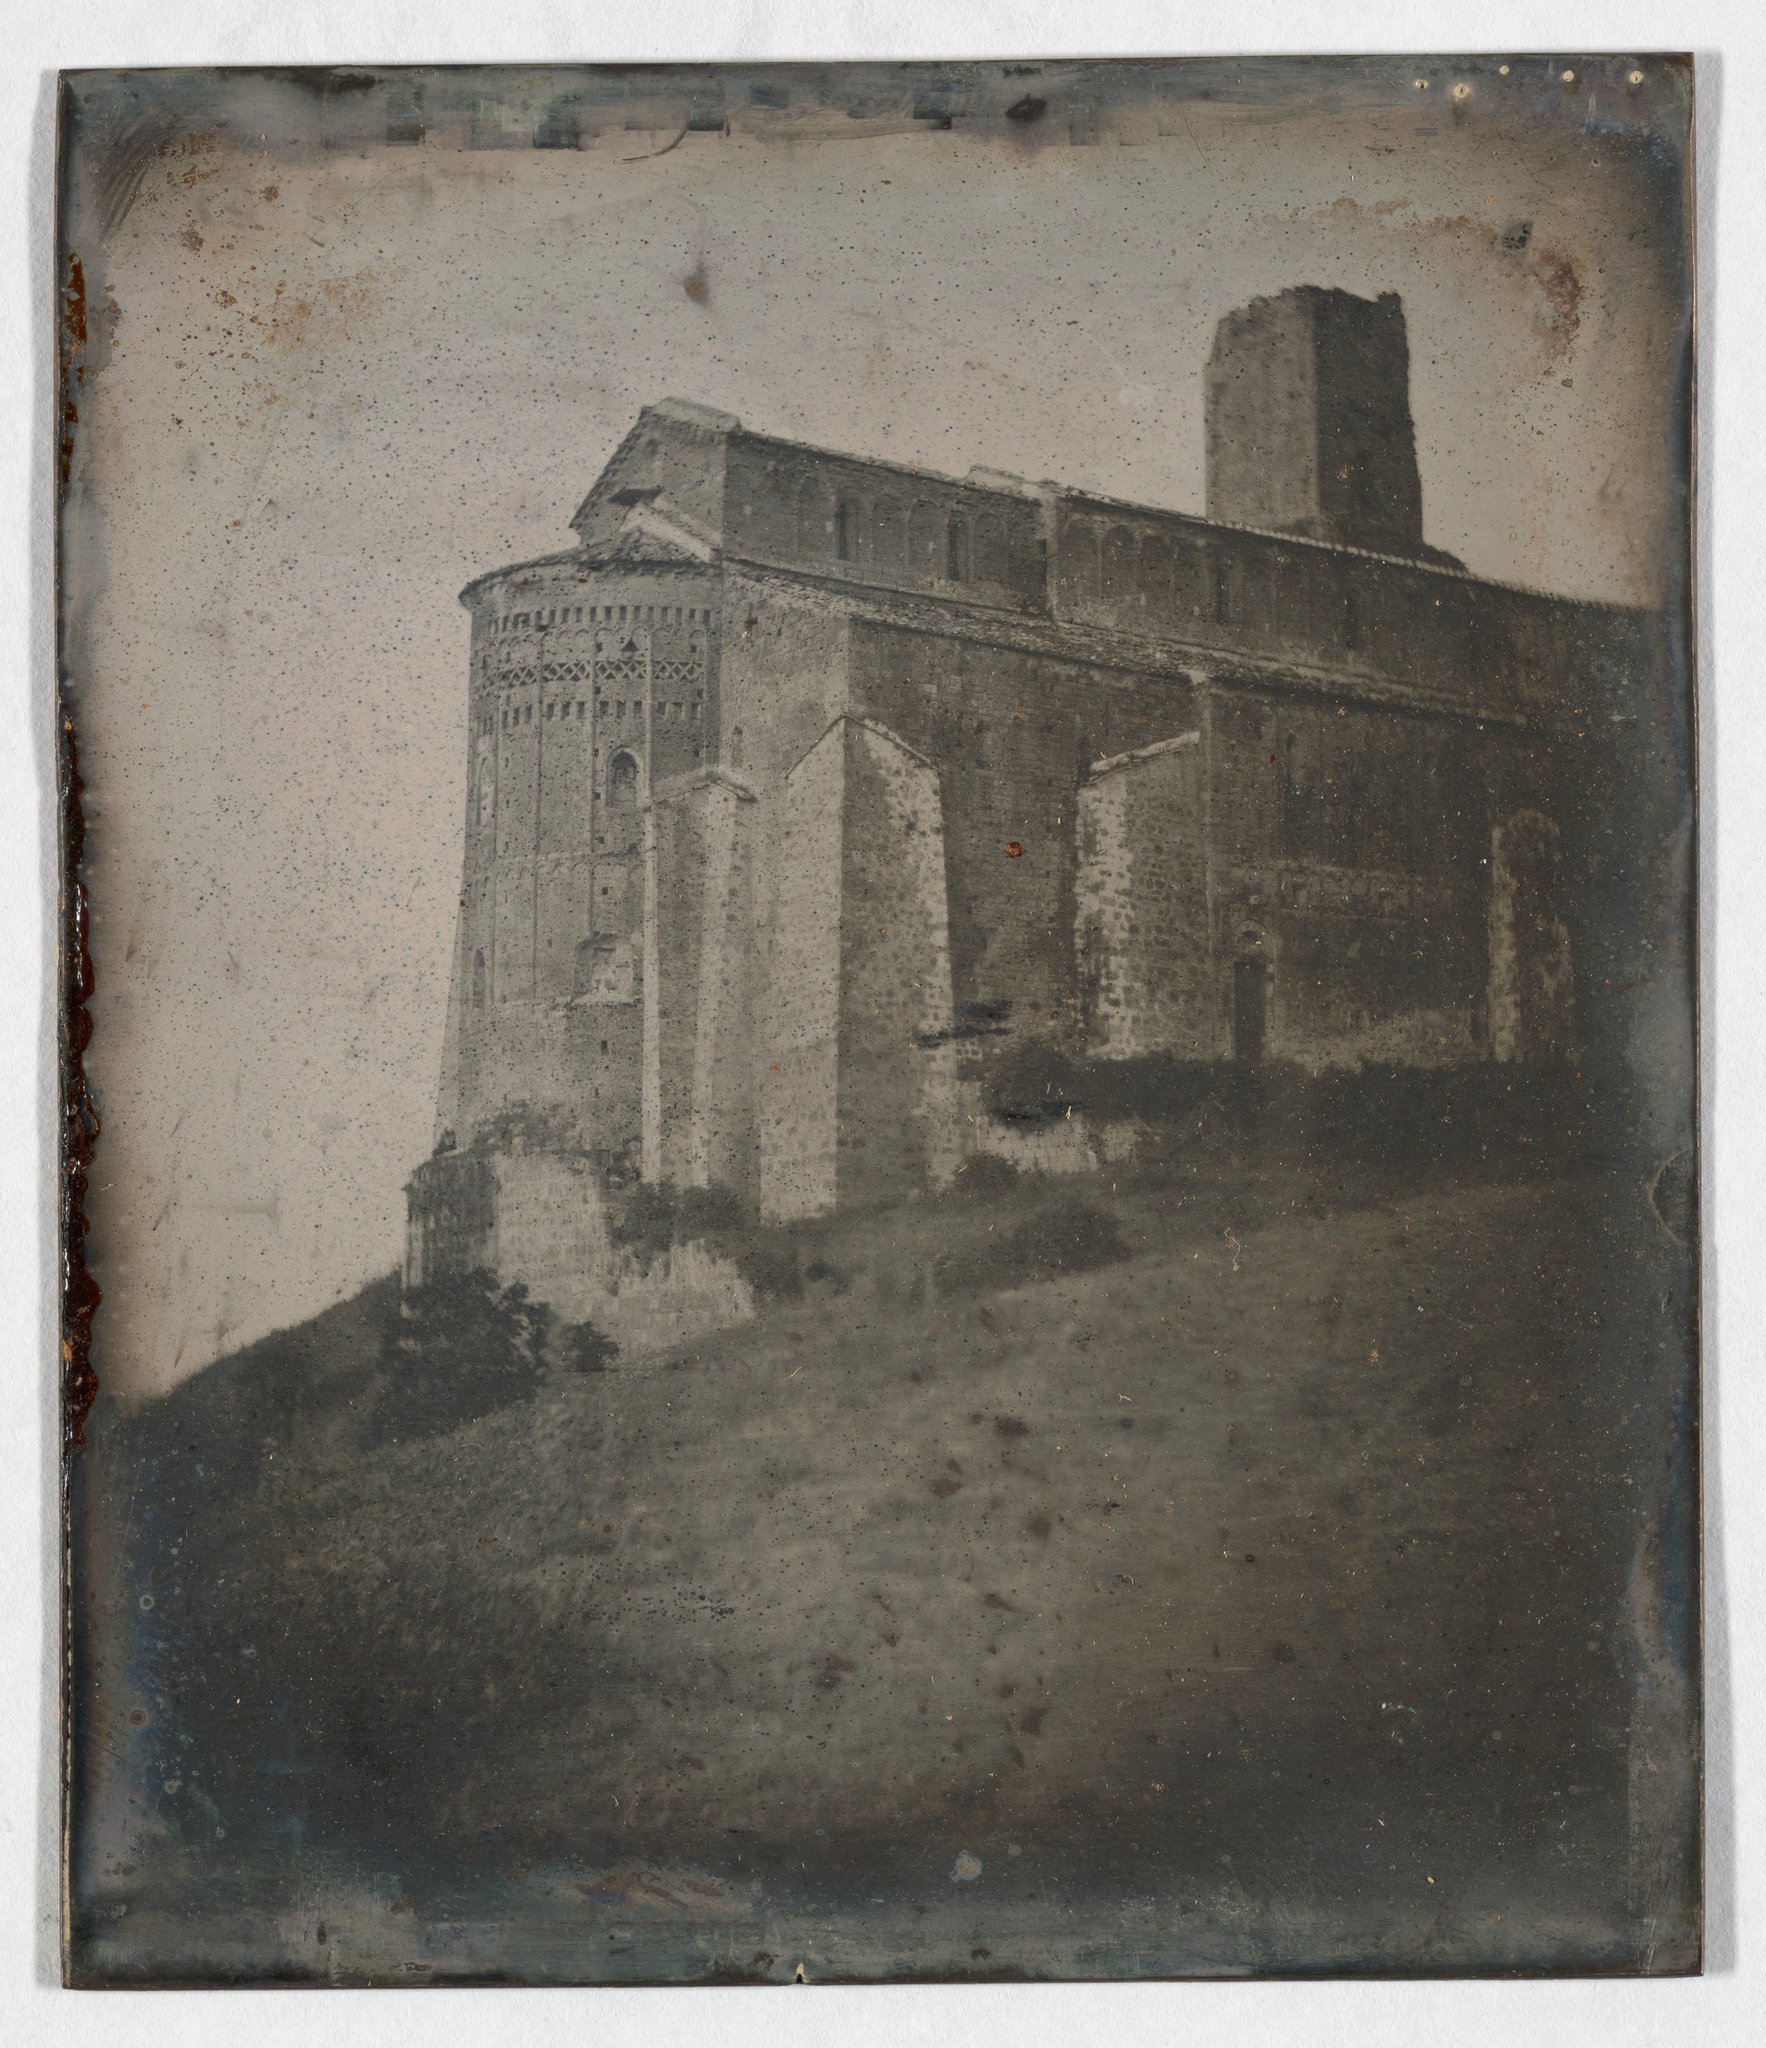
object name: photograph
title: Apse, Basilica San Pietro, Toscanella (Tuscania) (43. Toscanella. Eglise de S. Pietro. Apside.)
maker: joseph-philibert girault de prangey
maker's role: artist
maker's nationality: french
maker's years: 1804-1892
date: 1842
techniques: daguerreotype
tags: architecture,churches